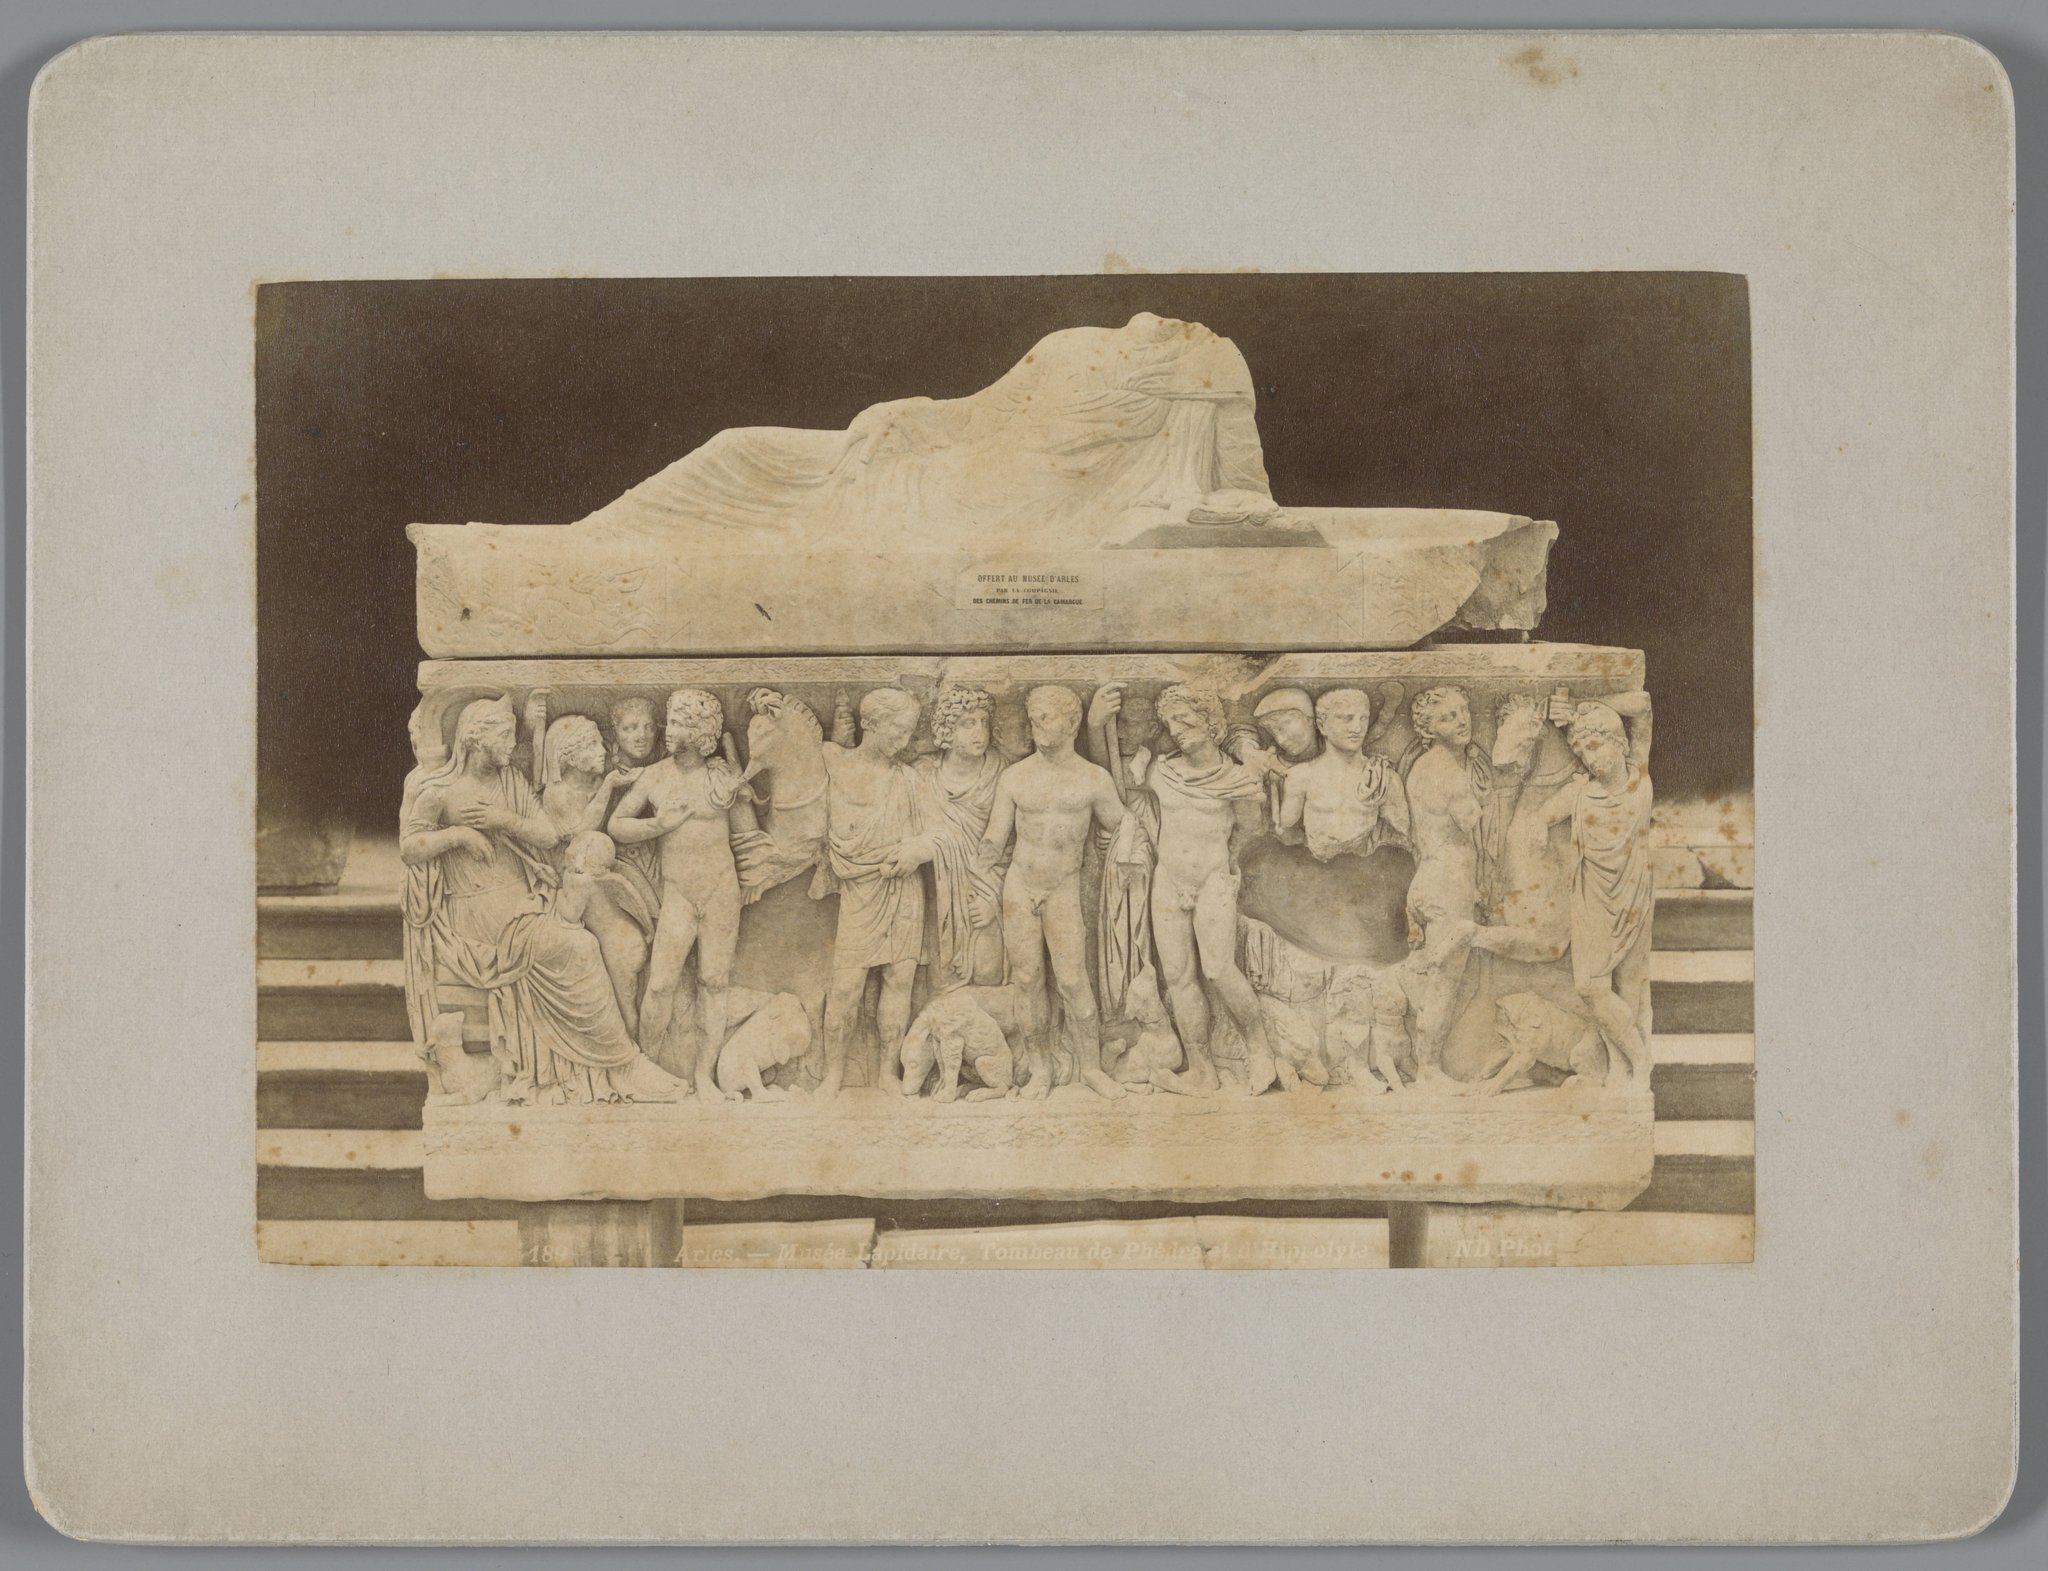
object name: photograph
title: Sarcofaag in museum te Arles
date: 1860-1915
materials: cardboard, paper, photographic support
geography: arles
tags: arles